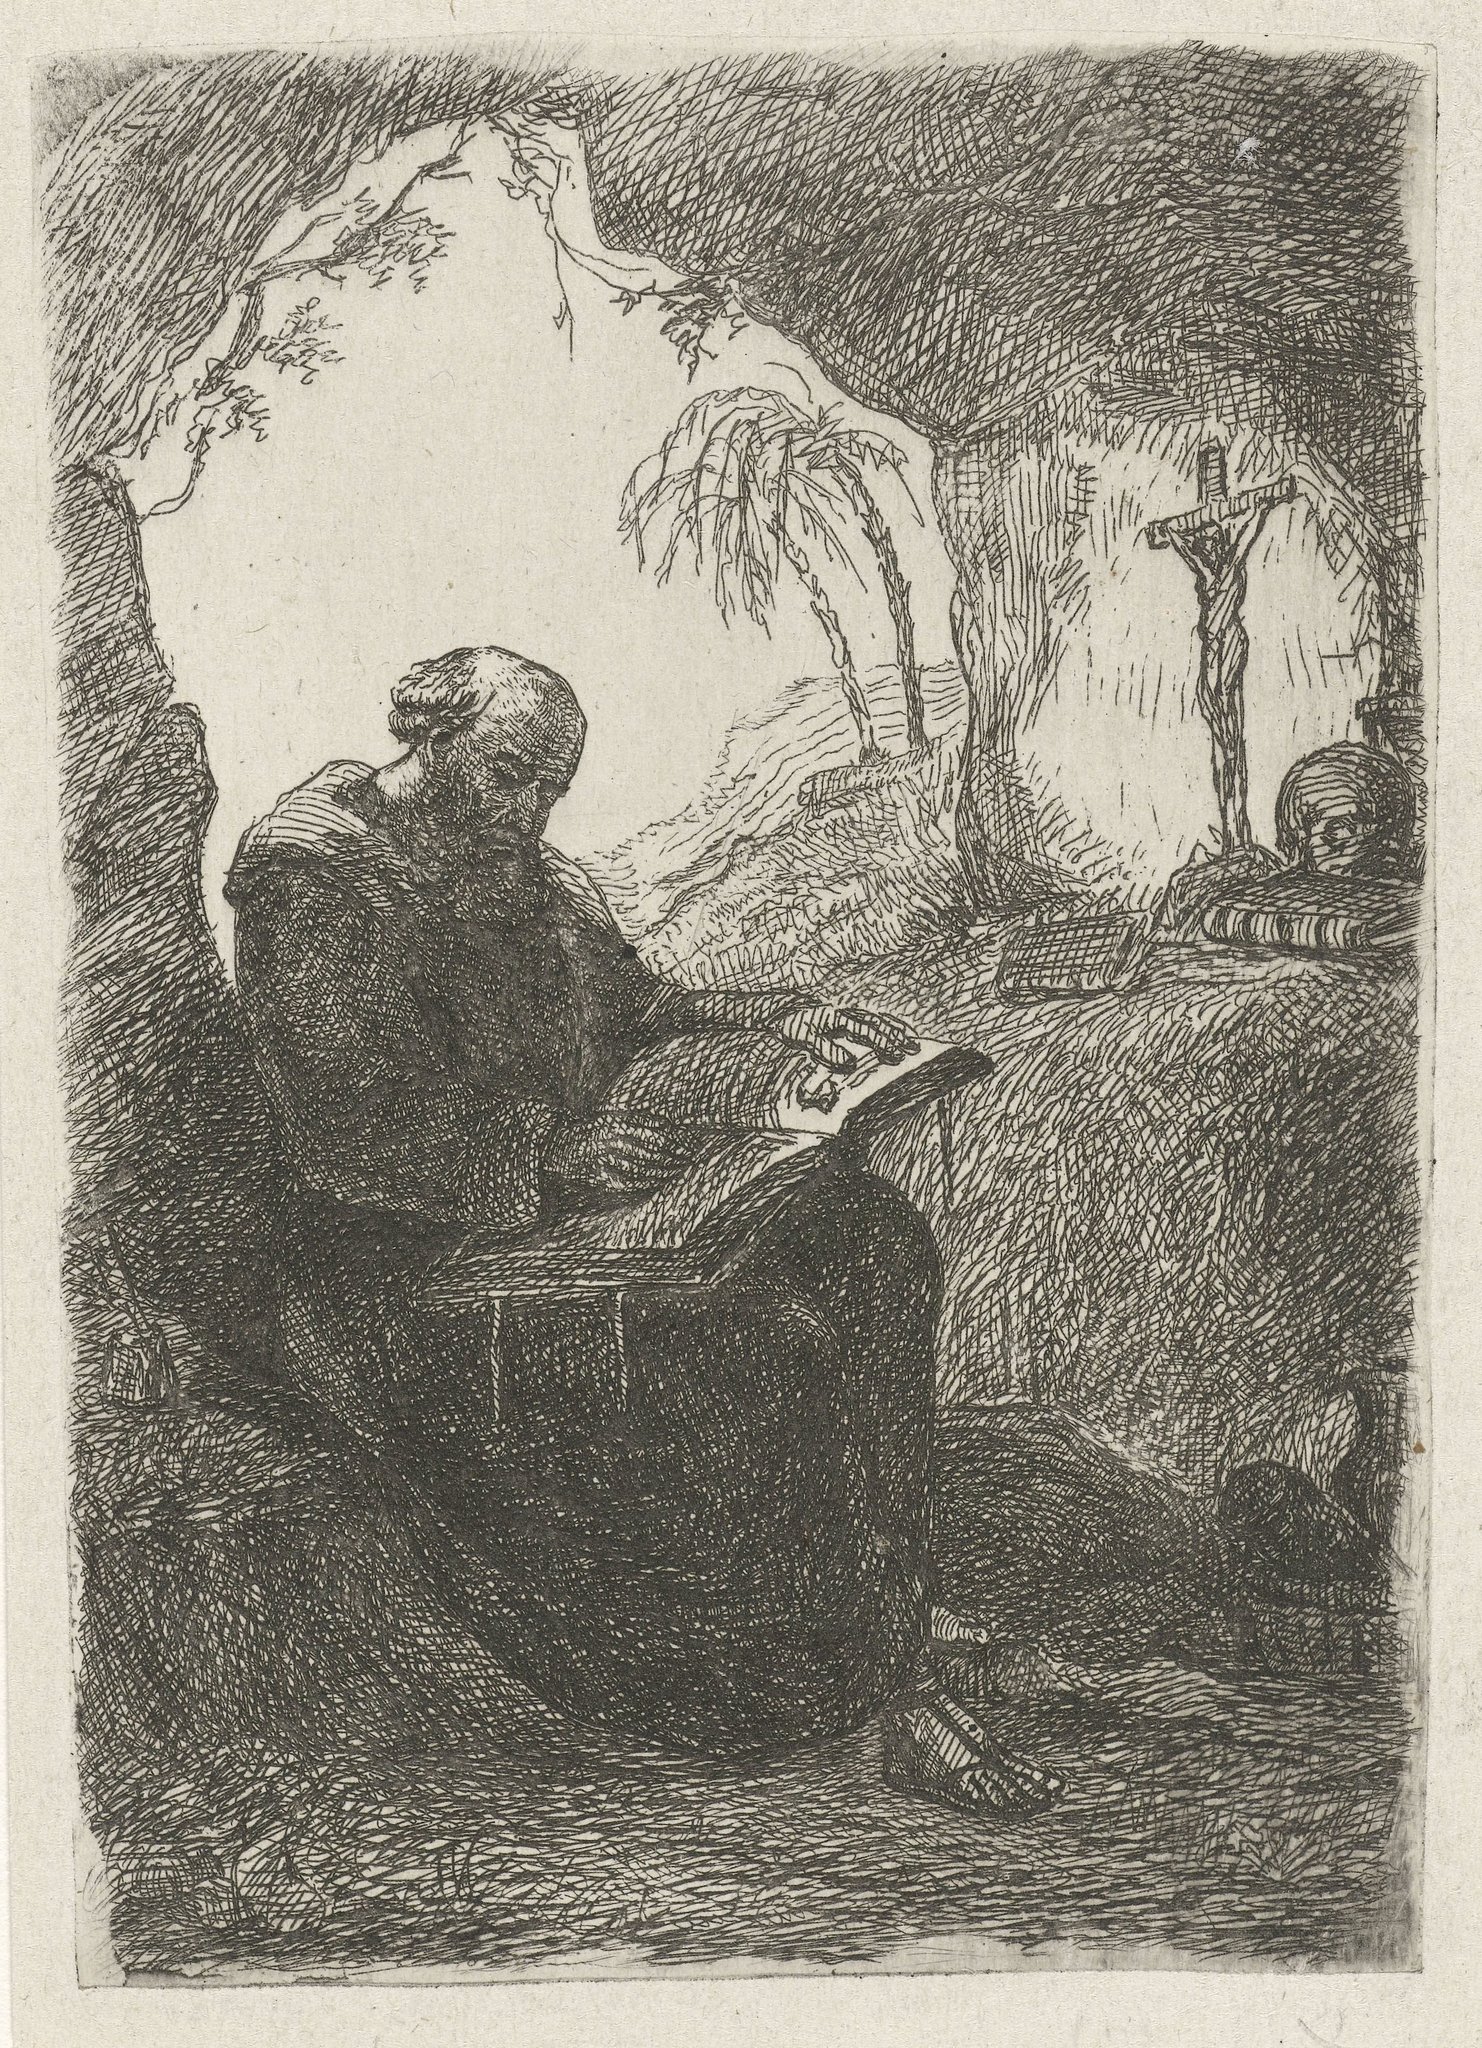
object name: print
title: Monnik in een grot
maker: david van der kellen (1804-1879)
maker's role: die cutter, draughtsman, print maker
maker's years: 1804-1879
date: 1814-1859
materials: paper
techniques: etching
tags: reading, monk(s), friar(s), crucifix ~ personal devotion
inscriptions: collector's mark: Lugt 2228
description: Een monnik zit bij de ingang van een grot een boek te lezen. Voor hem een crucifix, een schedel en boeken. Op de achtergrond twee palmbomen op een heuvel.